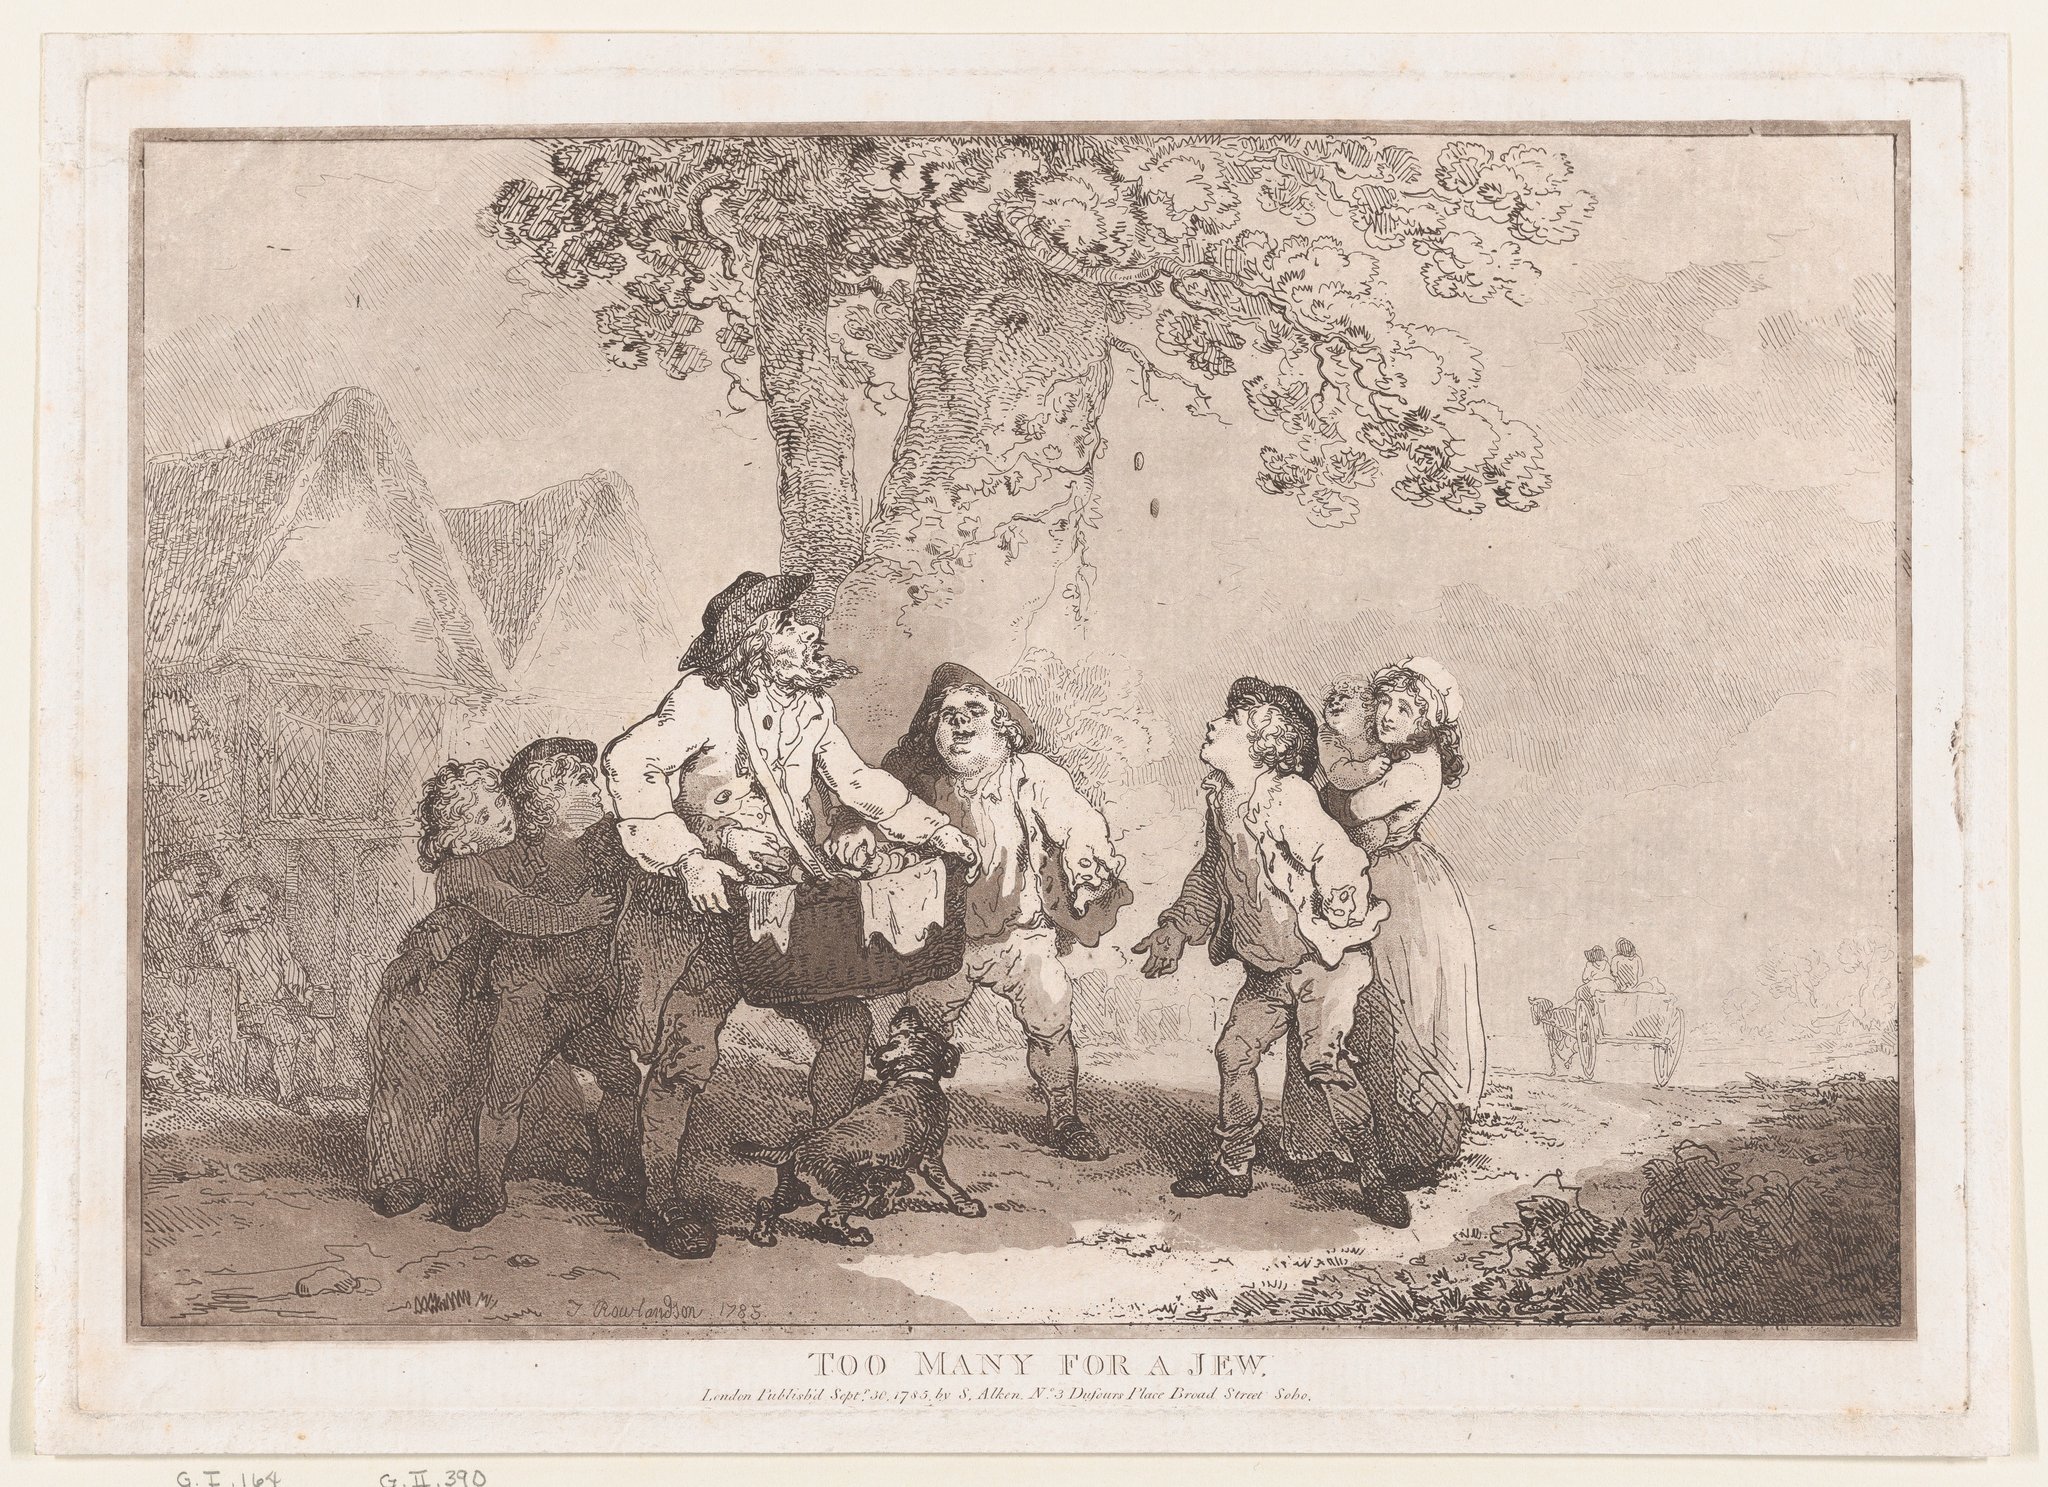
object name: print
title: Too Many for a Jew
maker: thomas rowlandson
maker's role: artist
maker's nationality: british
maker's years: 1757-1827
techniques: aquatint, etching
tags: boys,men,women